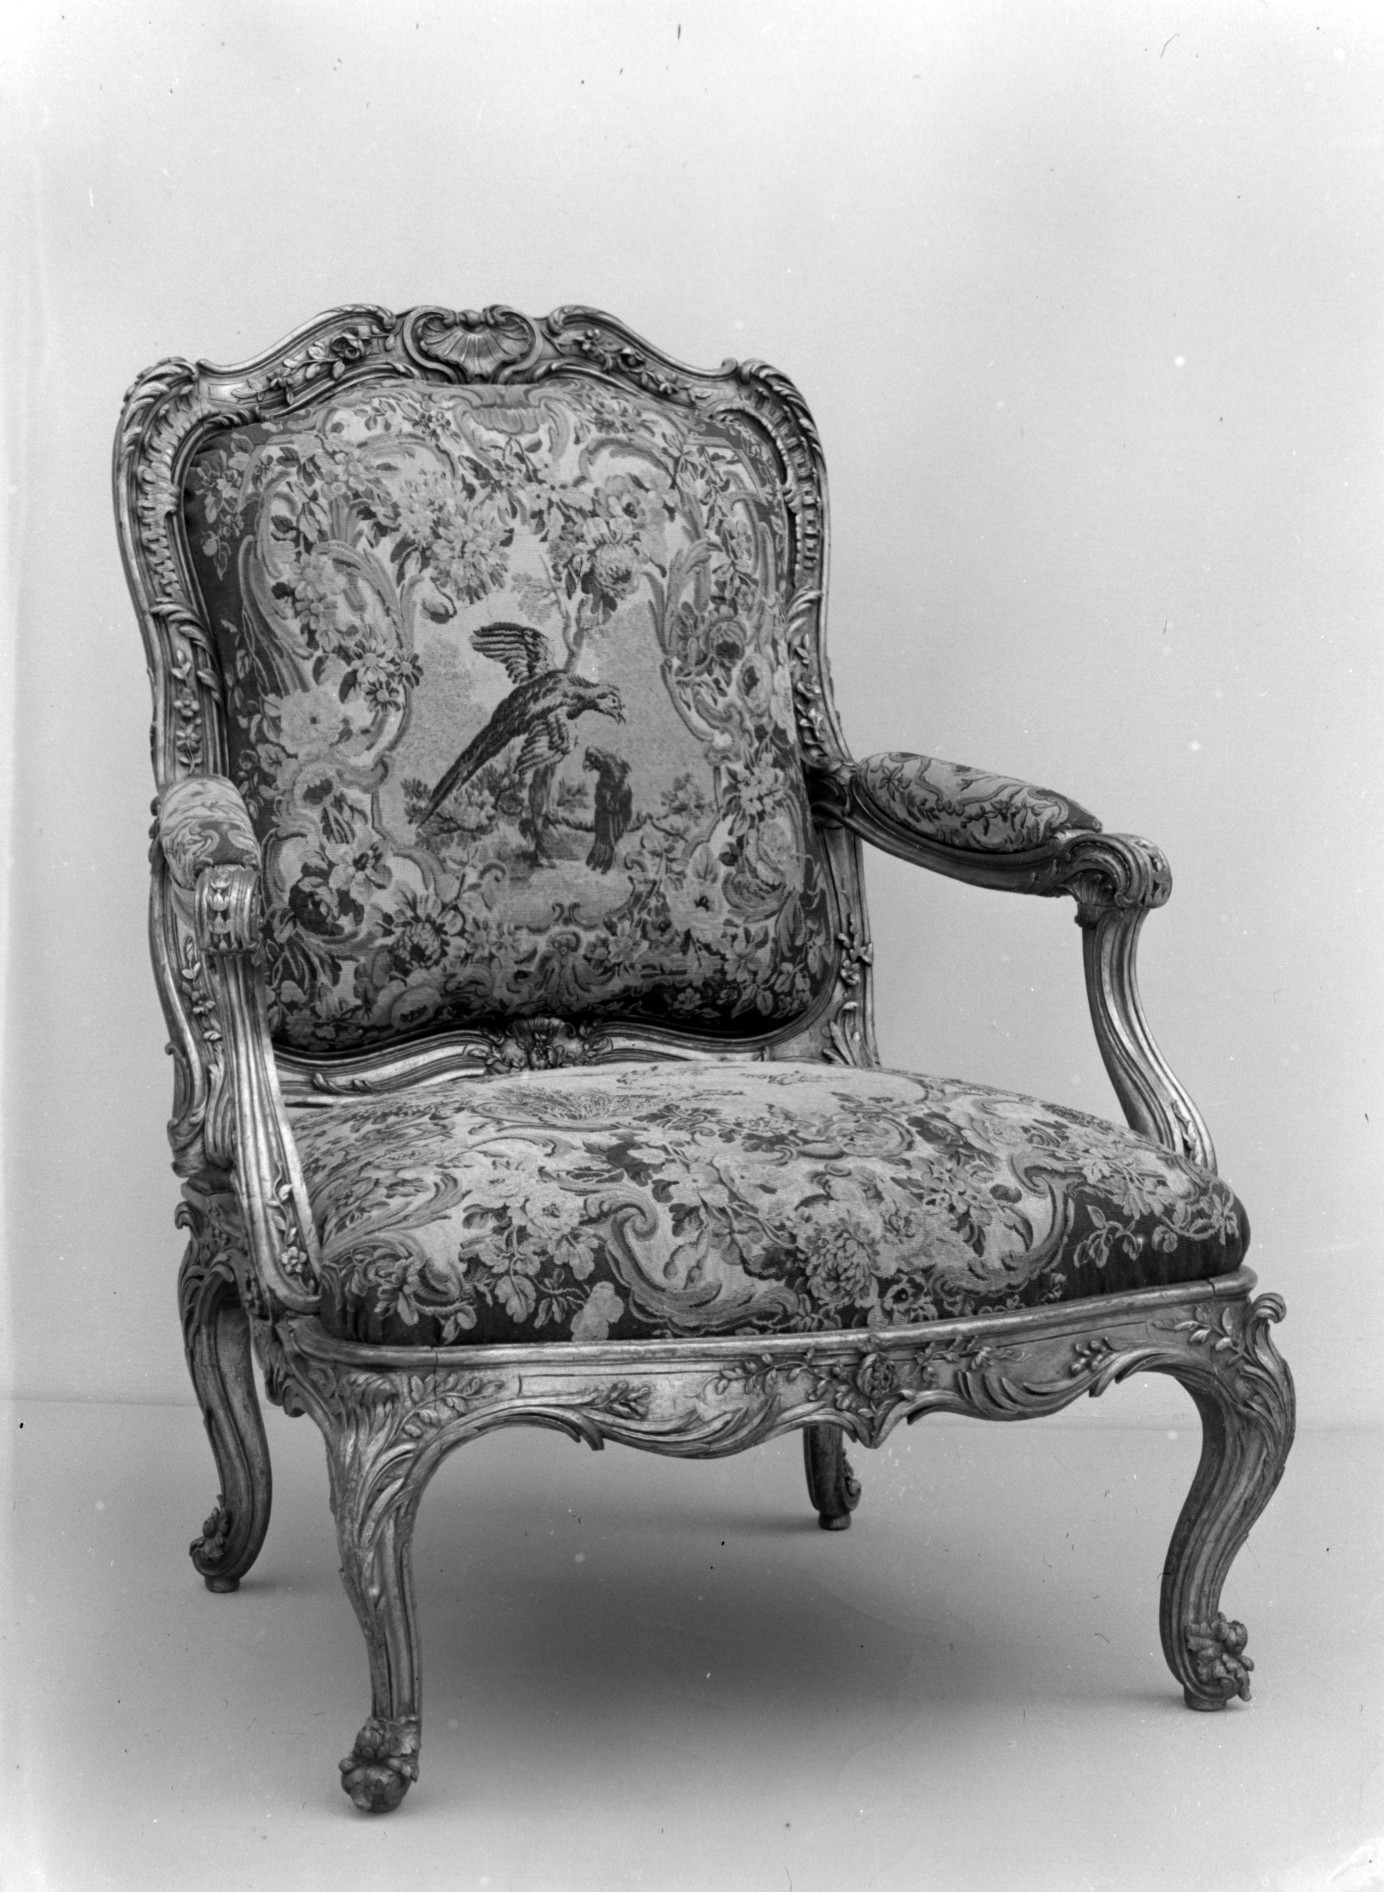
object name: upholstery panel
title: Armchair back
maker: beauvais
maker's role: manufactory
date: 1754-1756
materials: silk, wool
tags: birds,flowers